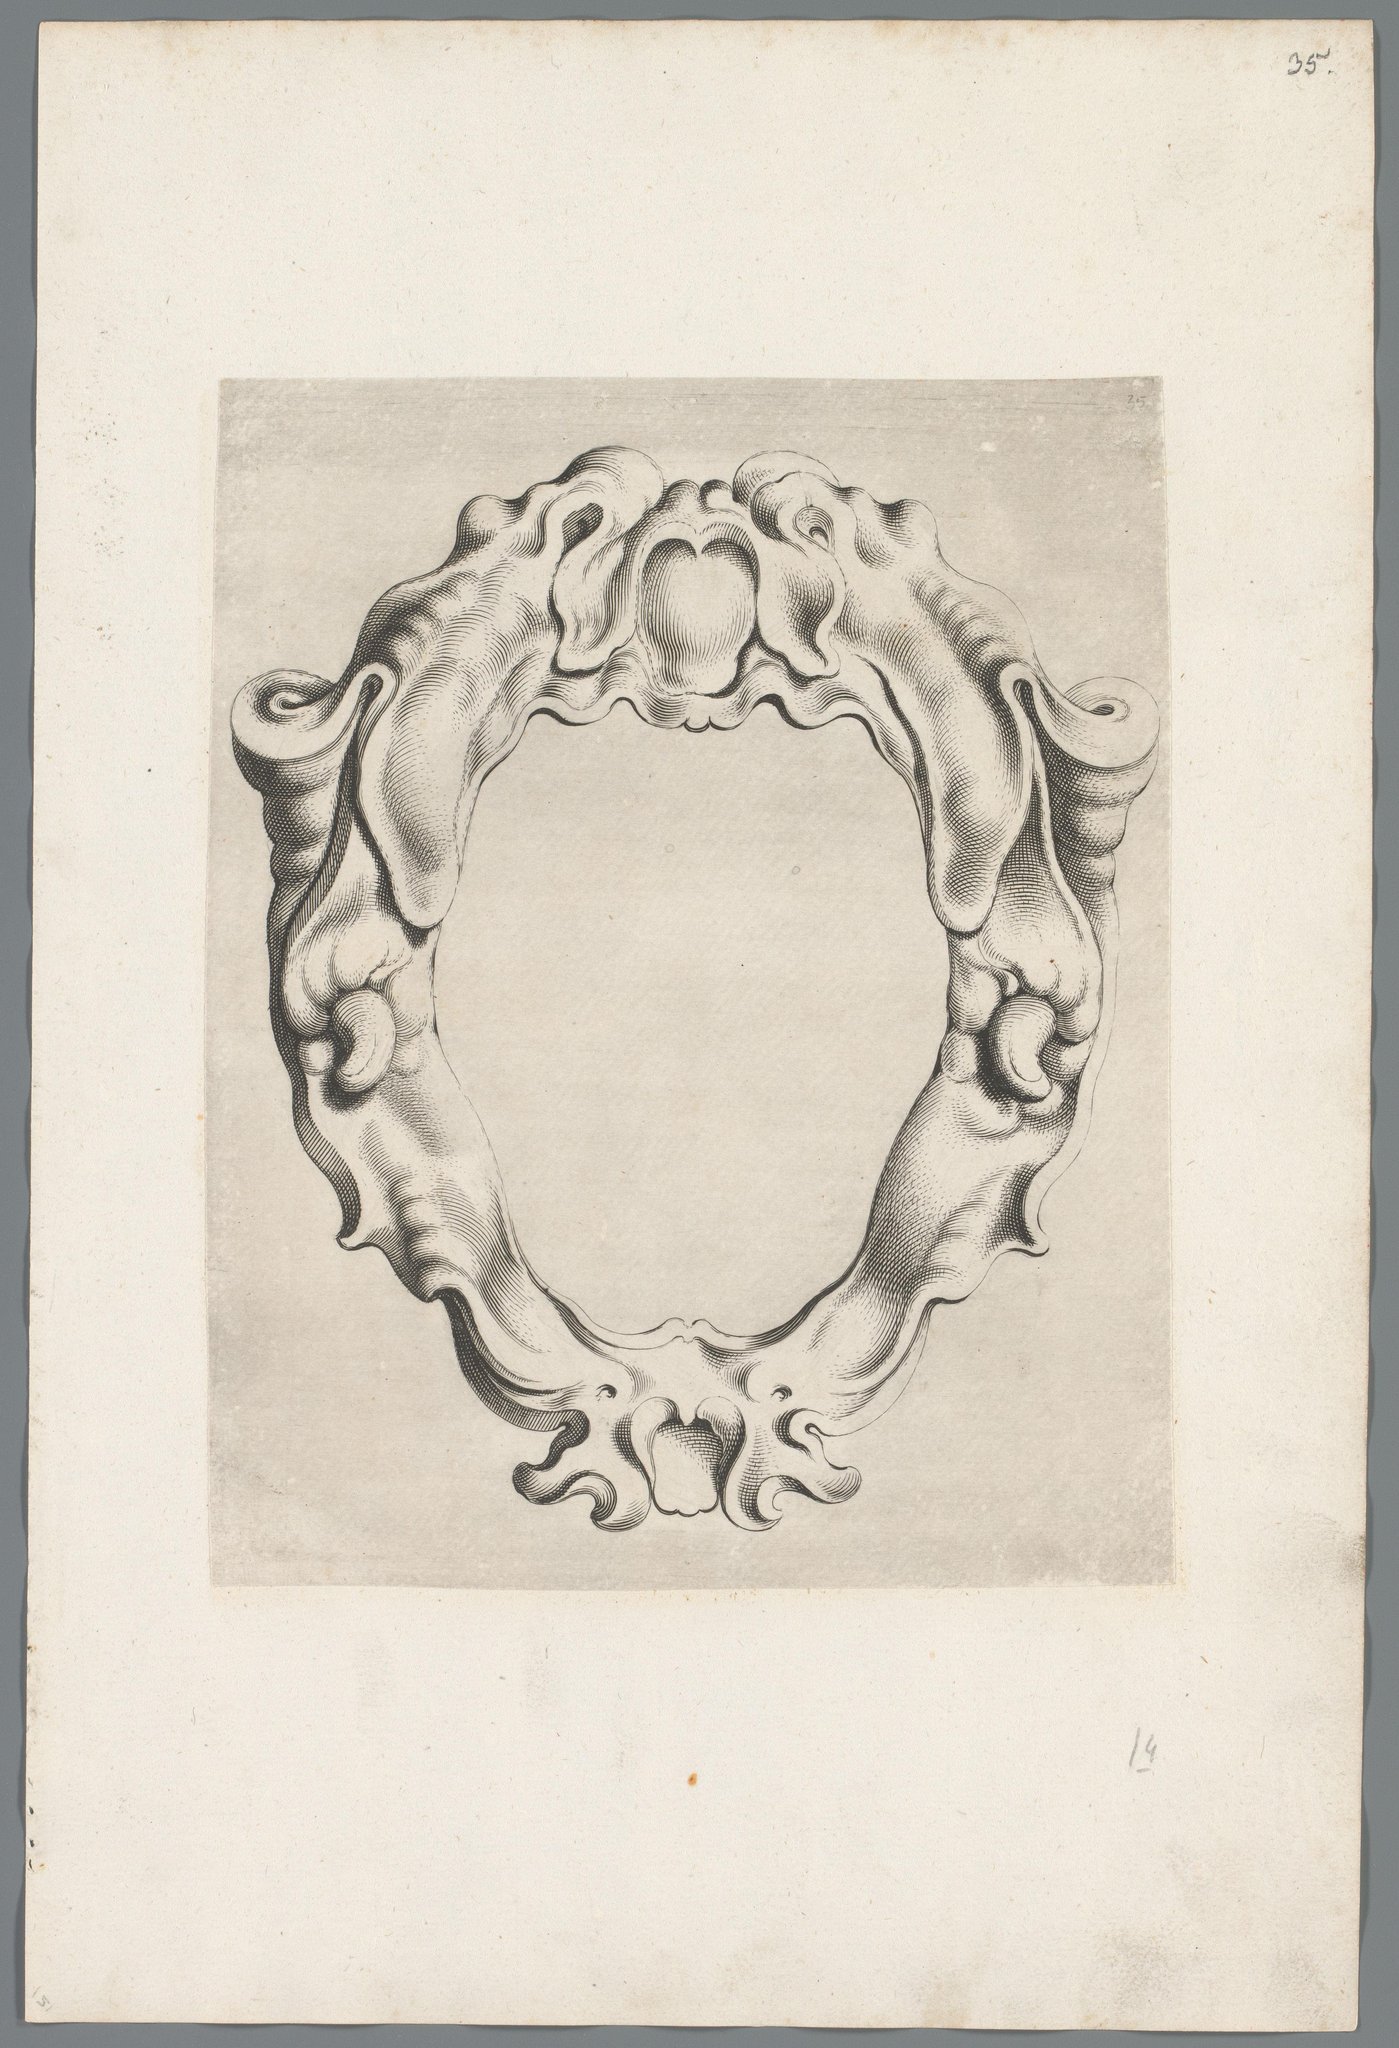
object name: ornament print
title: Veelderhande niewe compartemente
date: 1640-1674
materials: paper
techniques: engraving, etching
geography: amsterdam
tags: auricular ornament, lobe style ~ ornament, ornament ~ cartouche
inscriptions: collector's mark: Lugt 2760, collector's mark: Lugt 2228